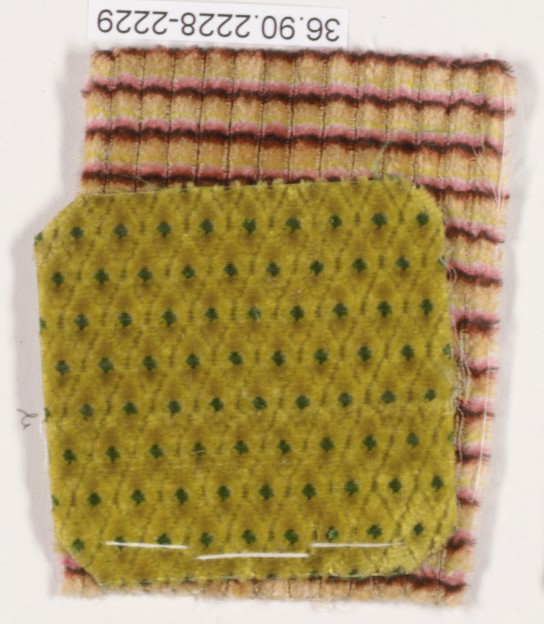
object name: piece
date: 1801-1900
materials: silk